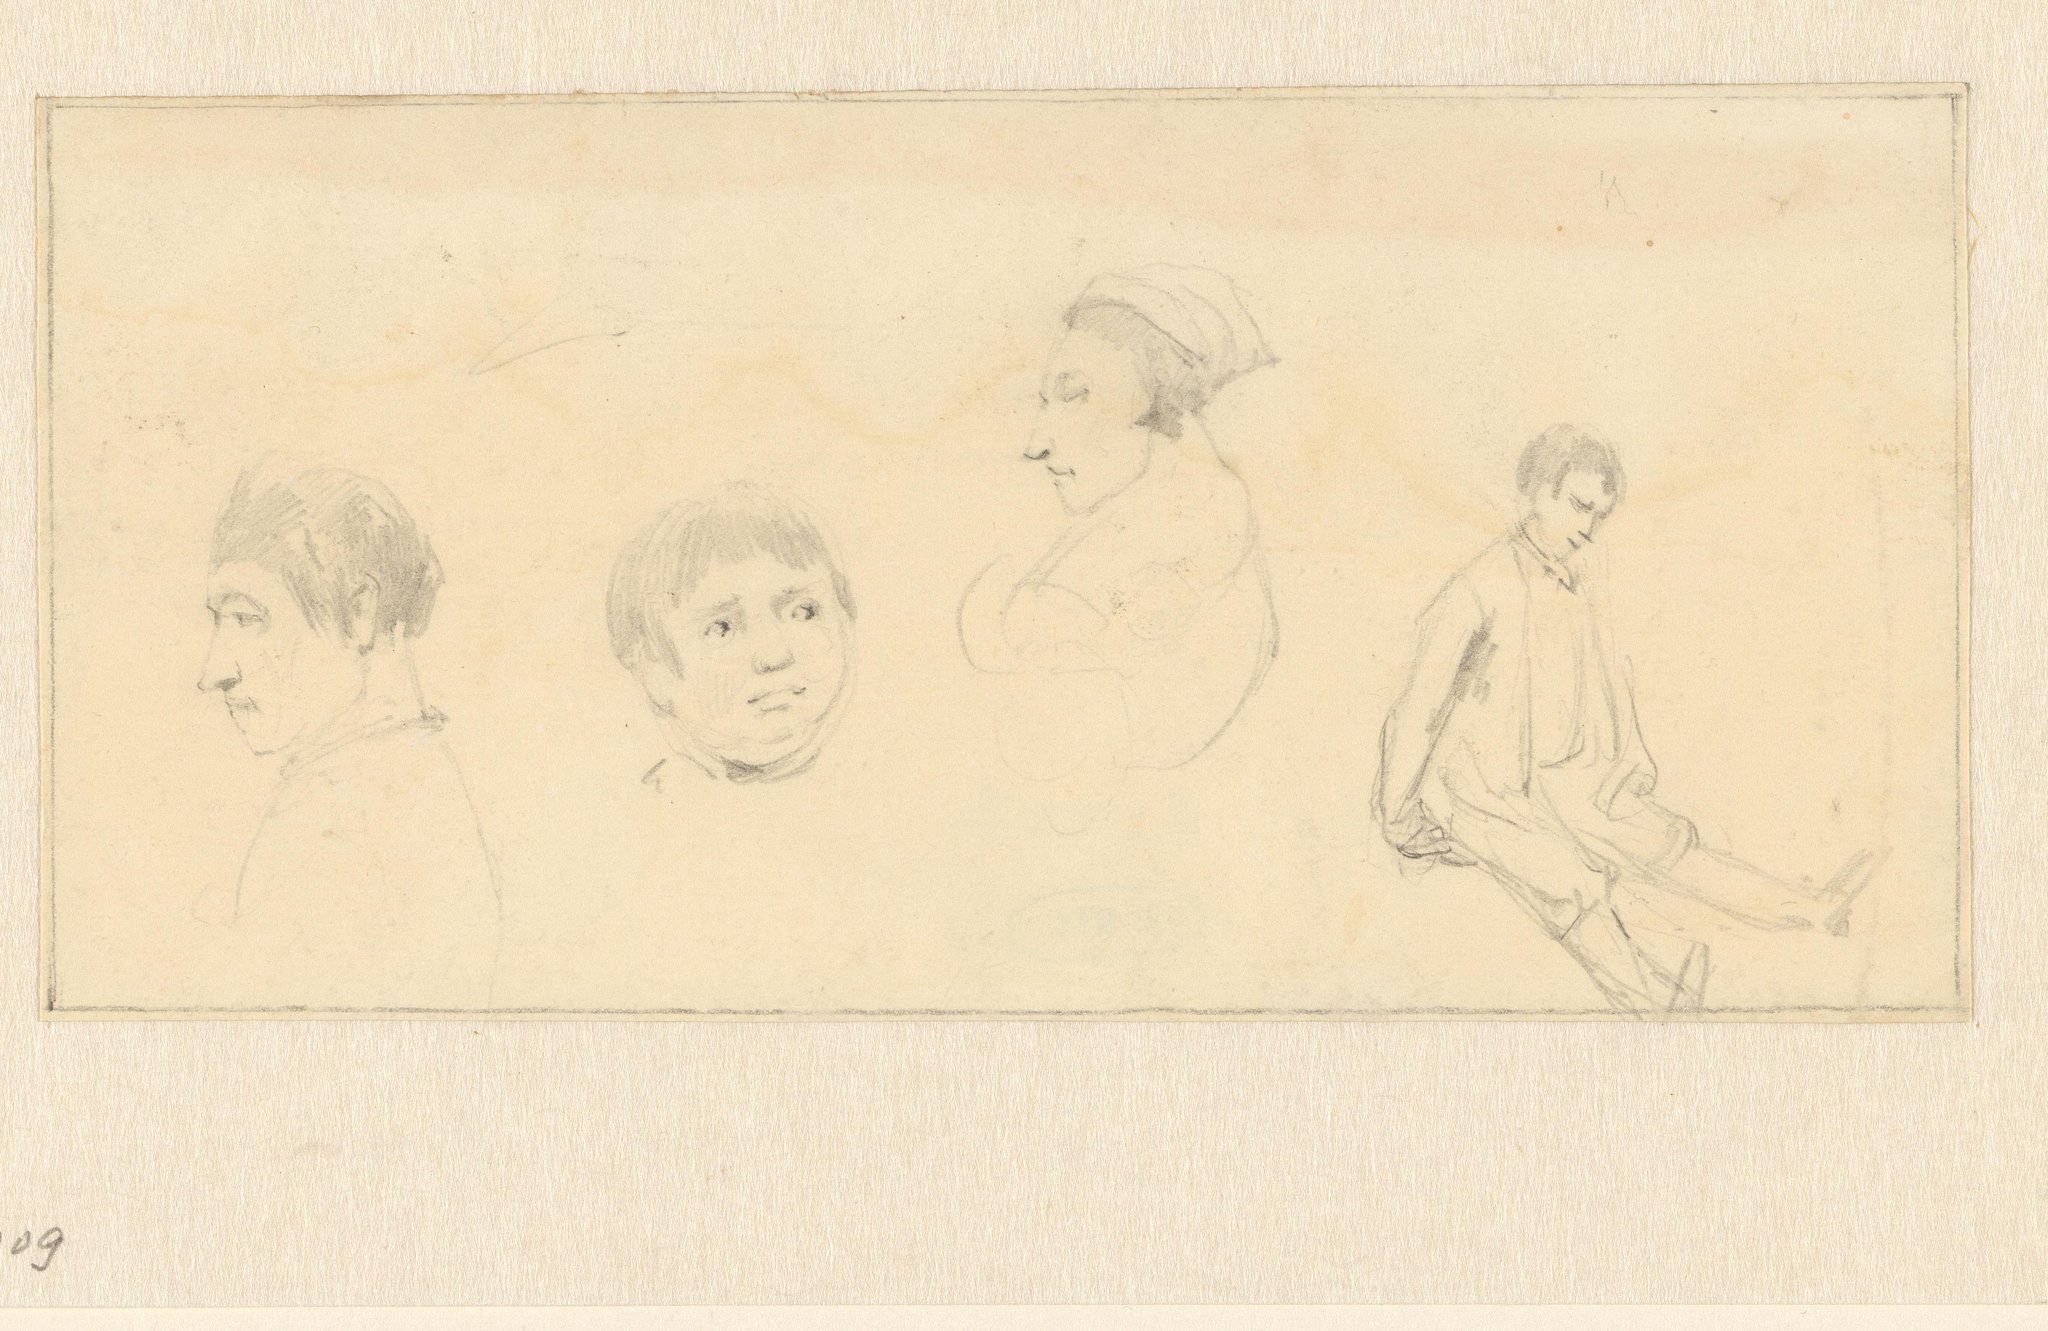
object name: drawing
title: Studieblad met drie schetsen van hoofden en een studie van een zittende man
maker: andreas schelfhout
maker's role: draughtsman, painter, print maker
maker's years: 1787-1870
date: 1797-1870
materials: paper, pencil